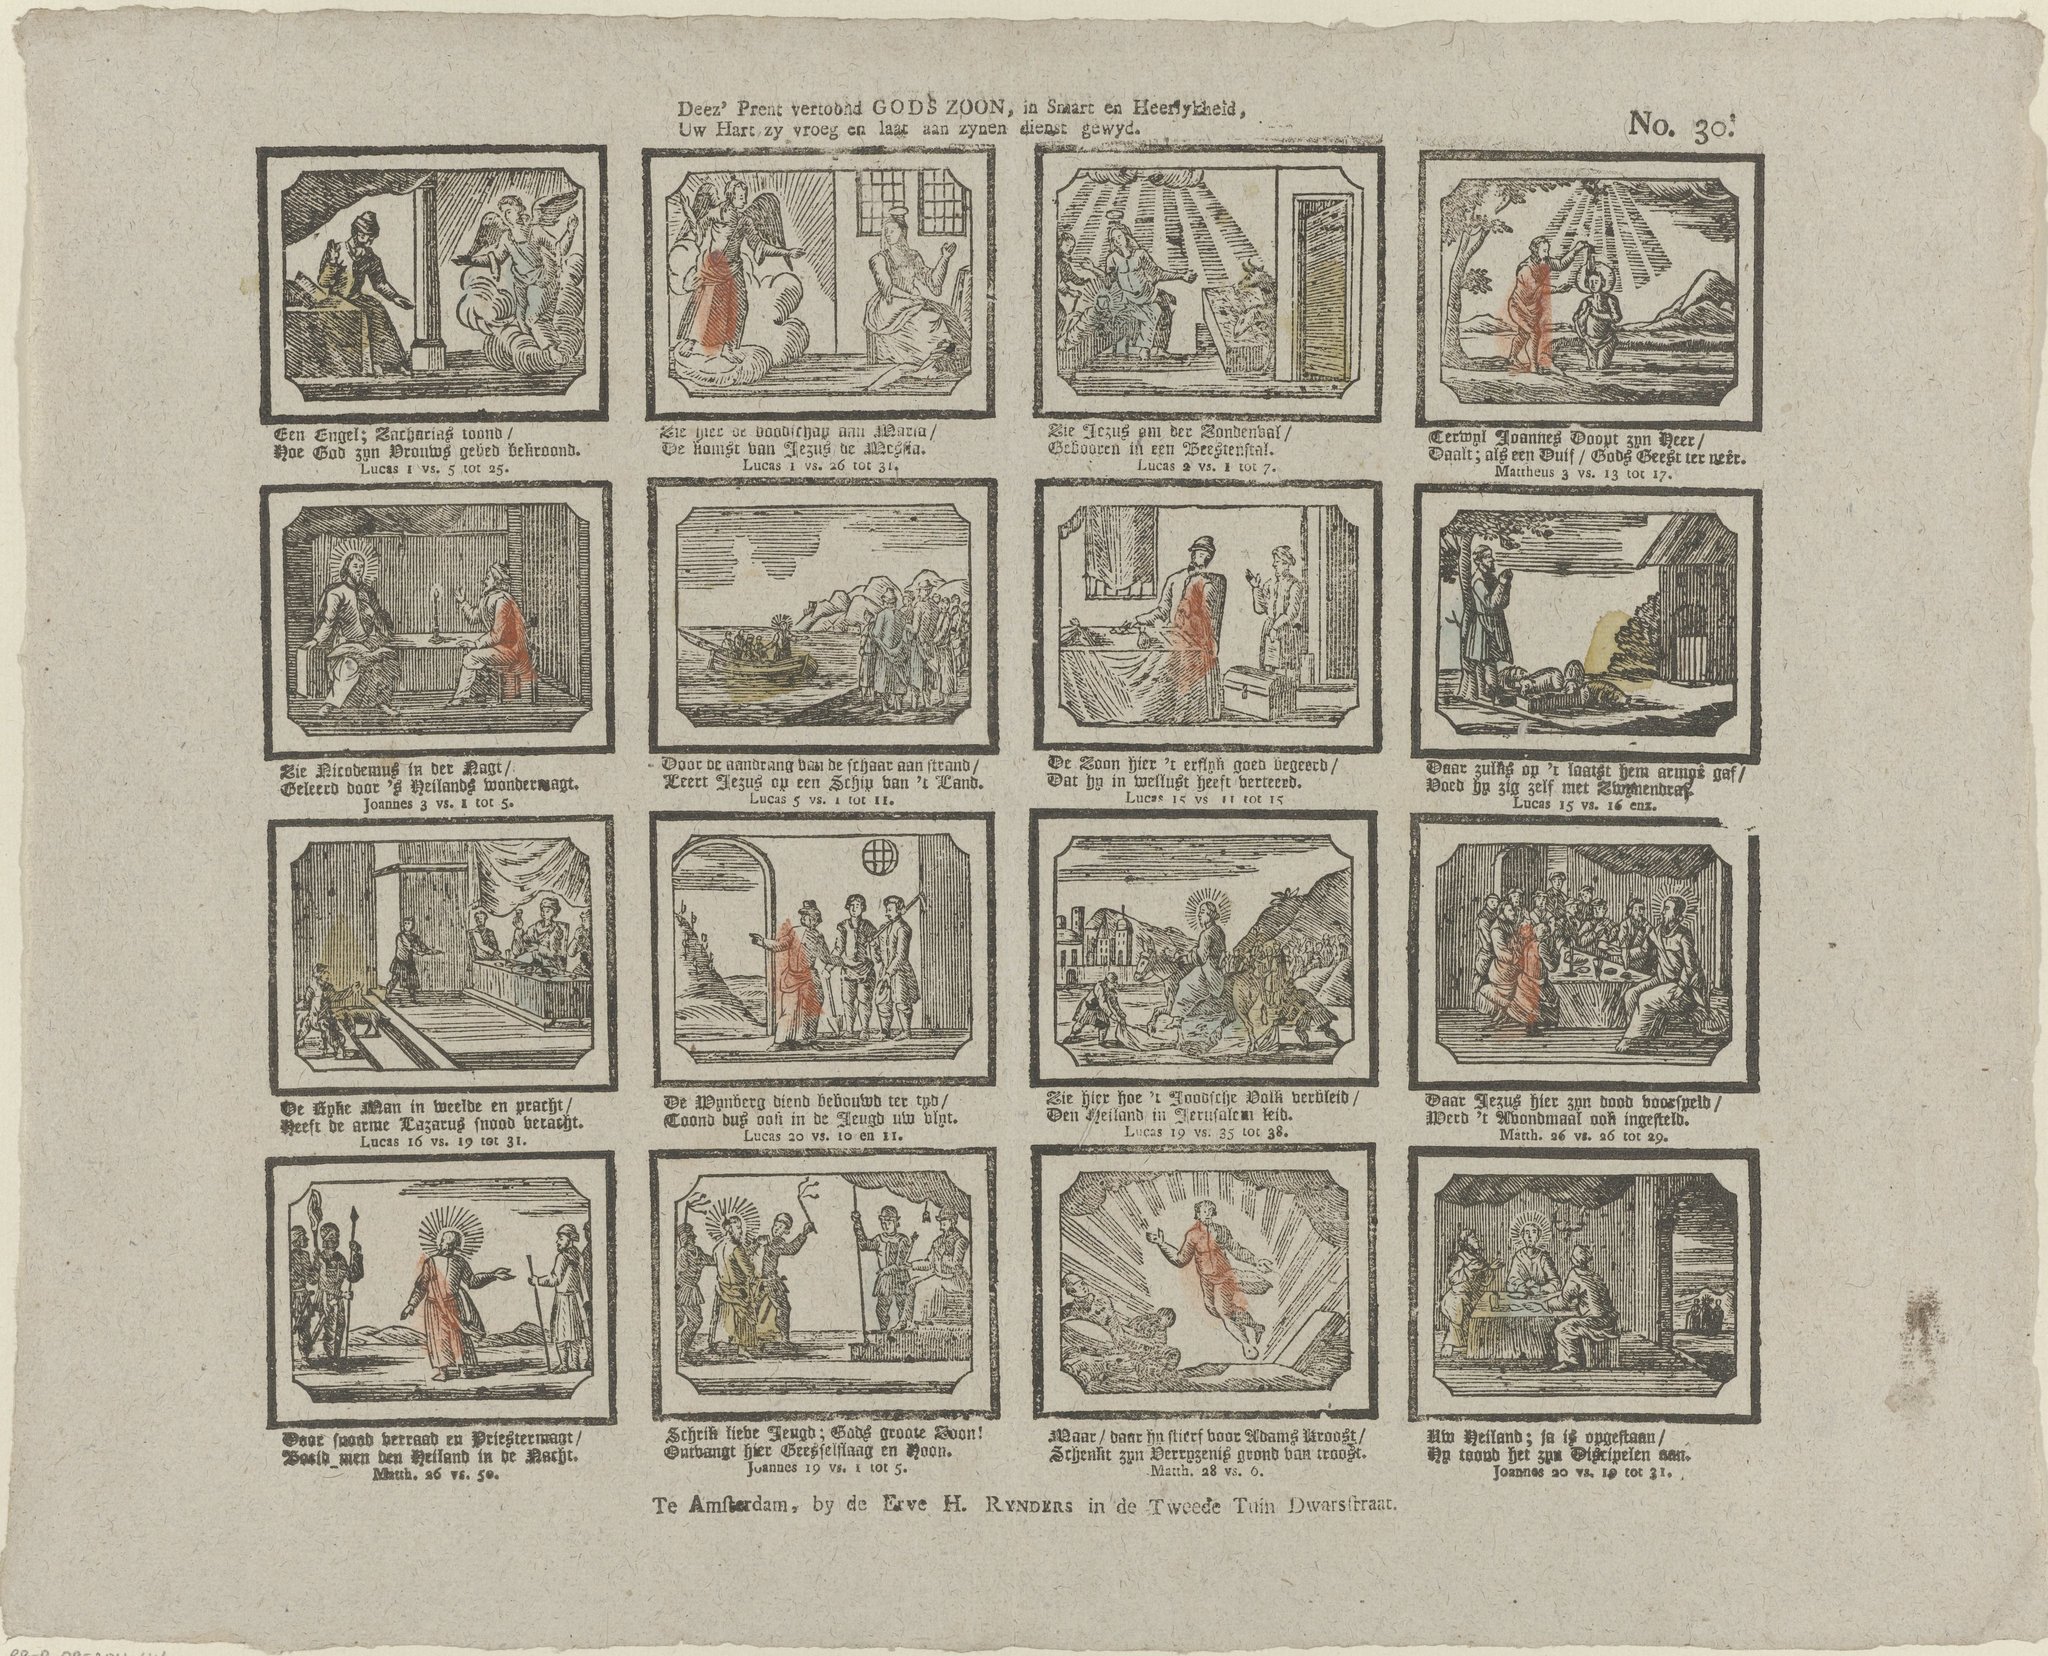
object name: print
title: Deez' prent vertoond Gods zoon, in smart en heerlykheid, / Uw hart zy vroeg en laat aan zynen dienst gewyd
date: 1831-1854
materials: paper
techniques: colour, letterpress printing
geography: amsterdam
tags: new testament, series of scenes from the life of christ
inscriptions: collector's mark: Lugt 2760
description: Blad met 16 voorstellingen van verhalen uit het Nieuwe Testament, zoals de doop in de Jordaan en de intocht in Jerusalem. Onder elke afbeelding een tweeregelig vers en een verwijzing naar de bijbehorende Bijbeltekst. Genummerd rechtsboven: No. 30.